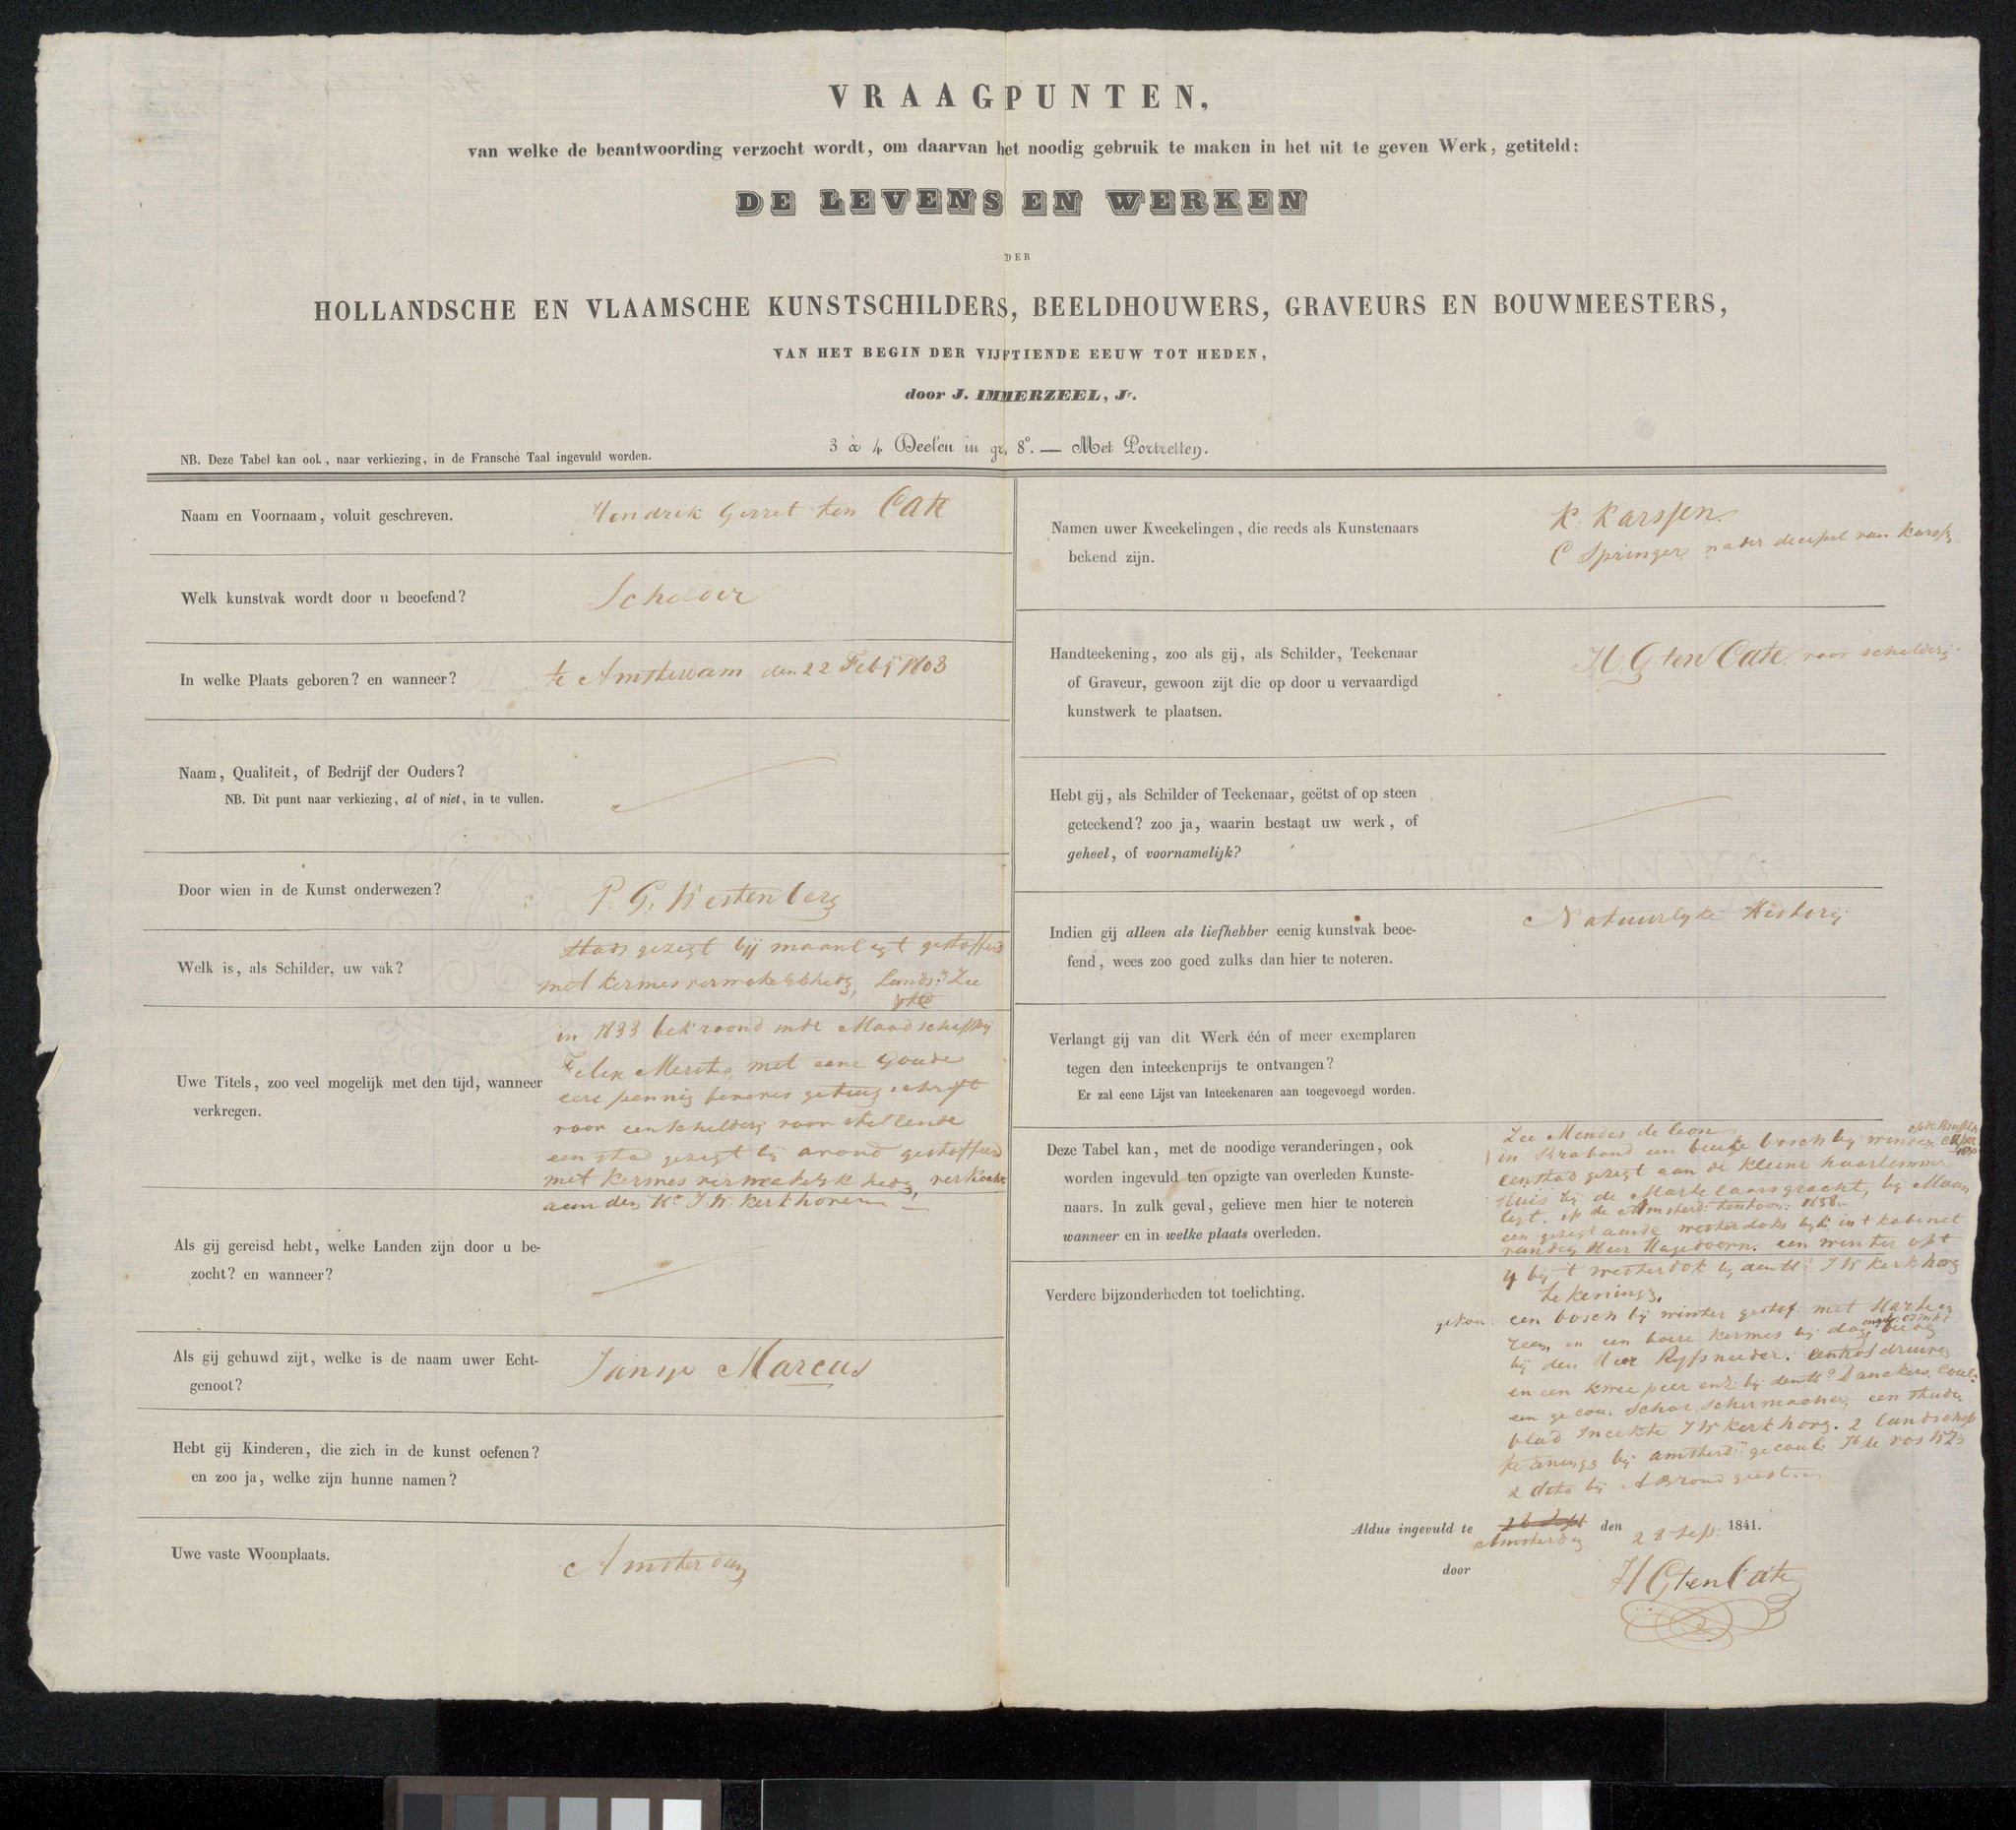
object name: manuscript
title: Enquêteformulier ingevuld door Hendrik Gerrit ten Cate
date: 1841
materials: ink, paper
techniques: pen, printing, writing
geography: amsterdam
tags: amsterdam, draughtsman, hendrik gerrit ten cate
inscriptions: watermark, inscription: ‘Vraagpunten,/ van welke de beantwoording verzocht wordt, om daarvan het noodig gebruik te maken in het uit te geven Werk, getiteld: De levens en werken/ der Hollandsche en Vlaamsche kunstschilders, beeldhouwers,/ graveurs en bouwmeesters, van het begin der vijftiende eeuw tot heden/ door J. Immerzeel, Jr.’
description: Opgenomen in: Immerzeel, J. Jr., De levens en werken der Hollandsche en Vlaamsche kunstschilders, beeldhouwers, graveurs en bouwmeesters, van het begin der vijftiende eeuw tot heden, Amsterdam: J.C. van Kesteren, 1842-1843.